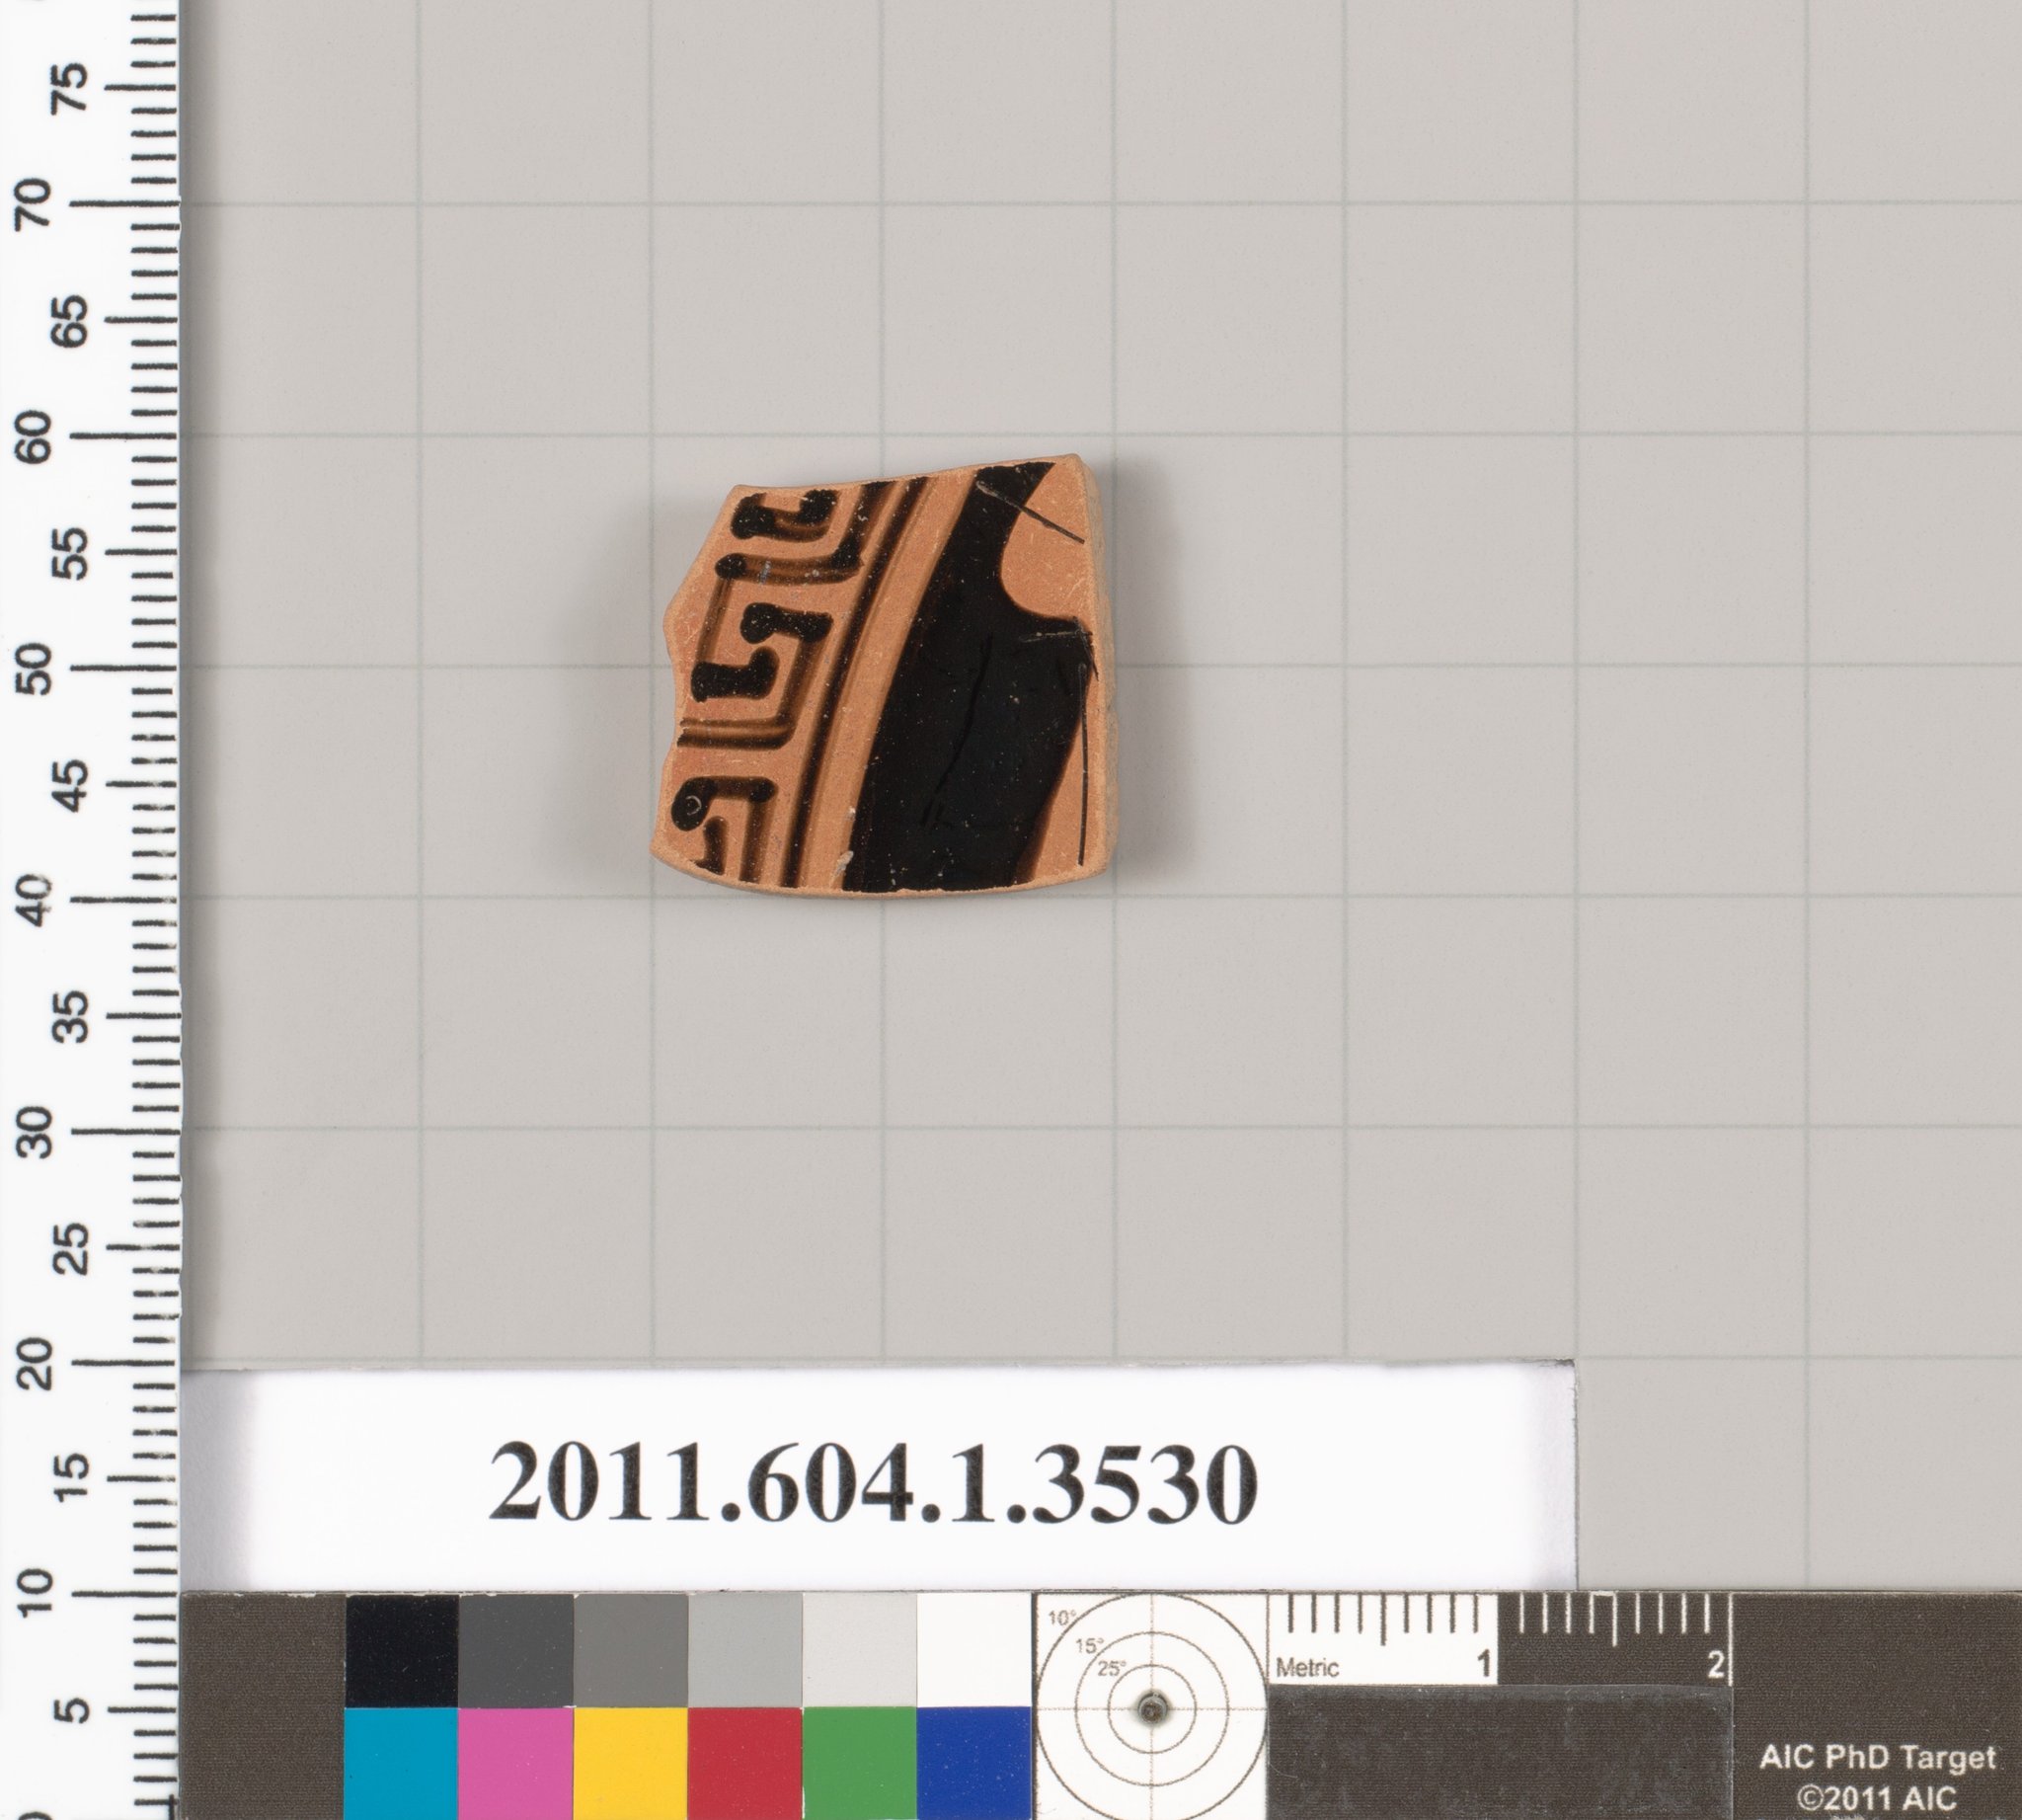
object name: kylix fragment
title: Terracotta fragment of a kylix (drinking cup)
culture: greek, attic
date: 475-451 BCE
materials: terracotta